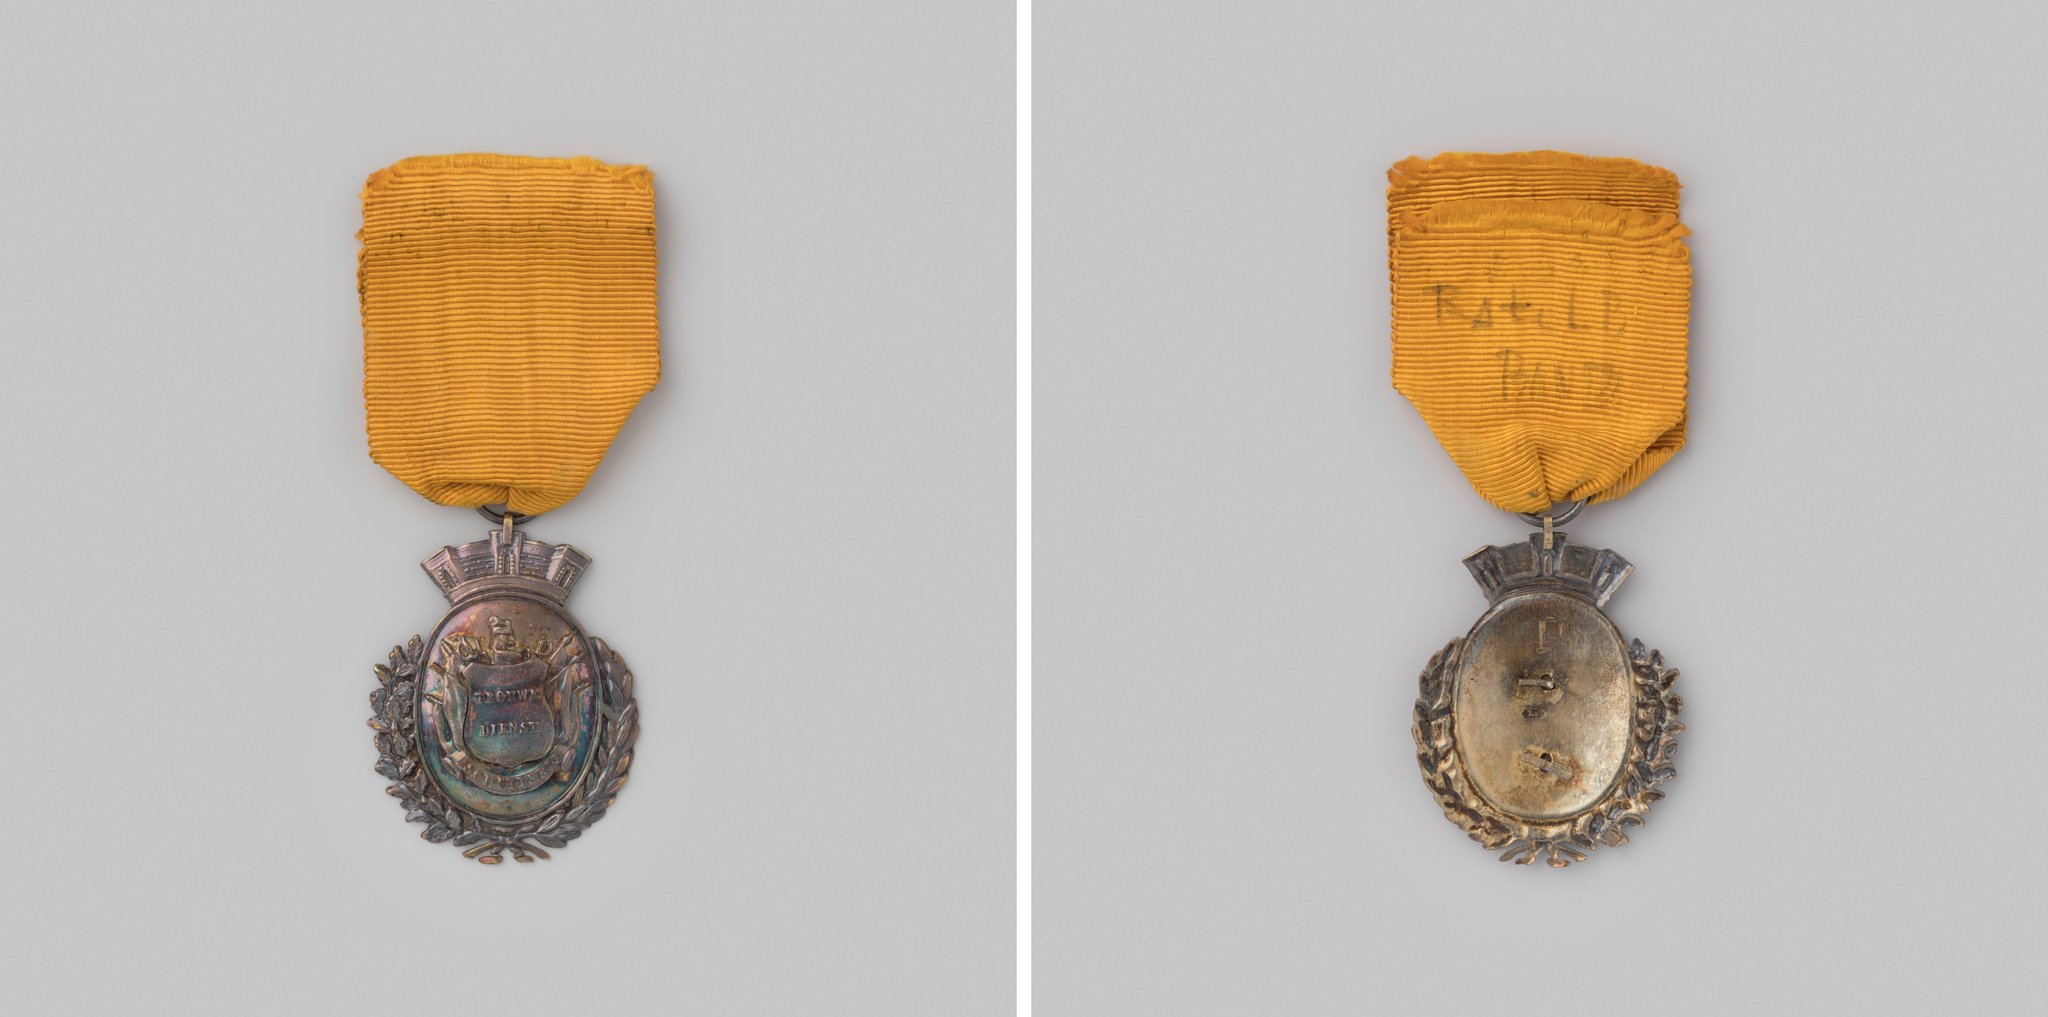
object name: honorary medal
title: Ereteken (verguld) voor dertig jaar eervolle, langdurige en werkelijke dienst bij de schutterij voor onderofficieren en minderen, gedragen door A.P. Ratelband, tamboer te Amsterdam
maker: Anonymous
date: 1851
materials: silver, textile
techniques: gilding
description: Zilveren draagpenning, geheel verguld, met knop, ring en lint.